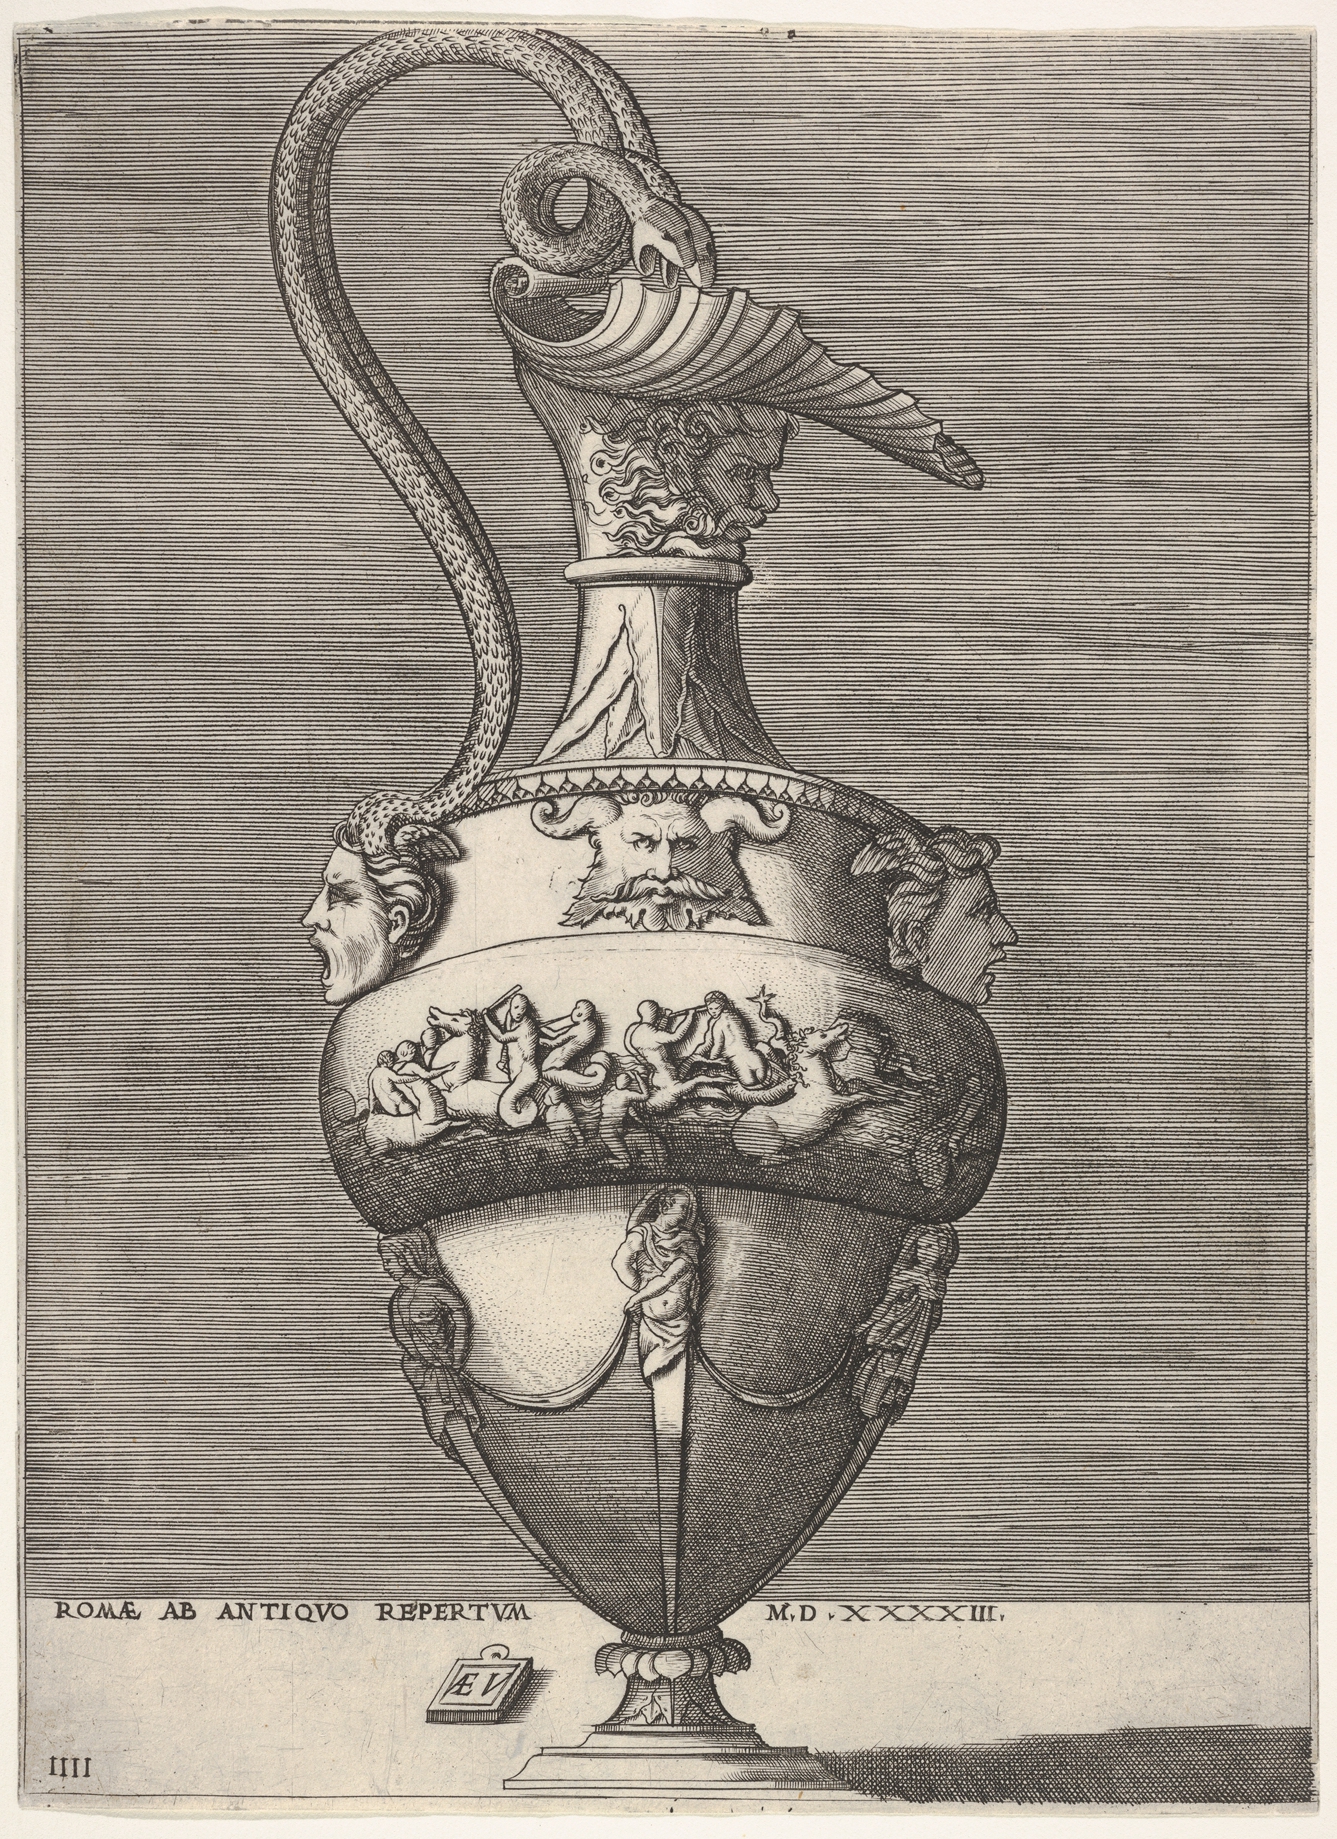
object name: print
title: Antique Ewer with a Handle in the Shape of Two Snakes coming from the Head of Medusa below, from "Vases after the Antique"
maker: enea vico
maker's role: artist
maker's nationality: italian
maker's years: 1523-1567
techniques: engraving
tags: medusa,snakes,ewers